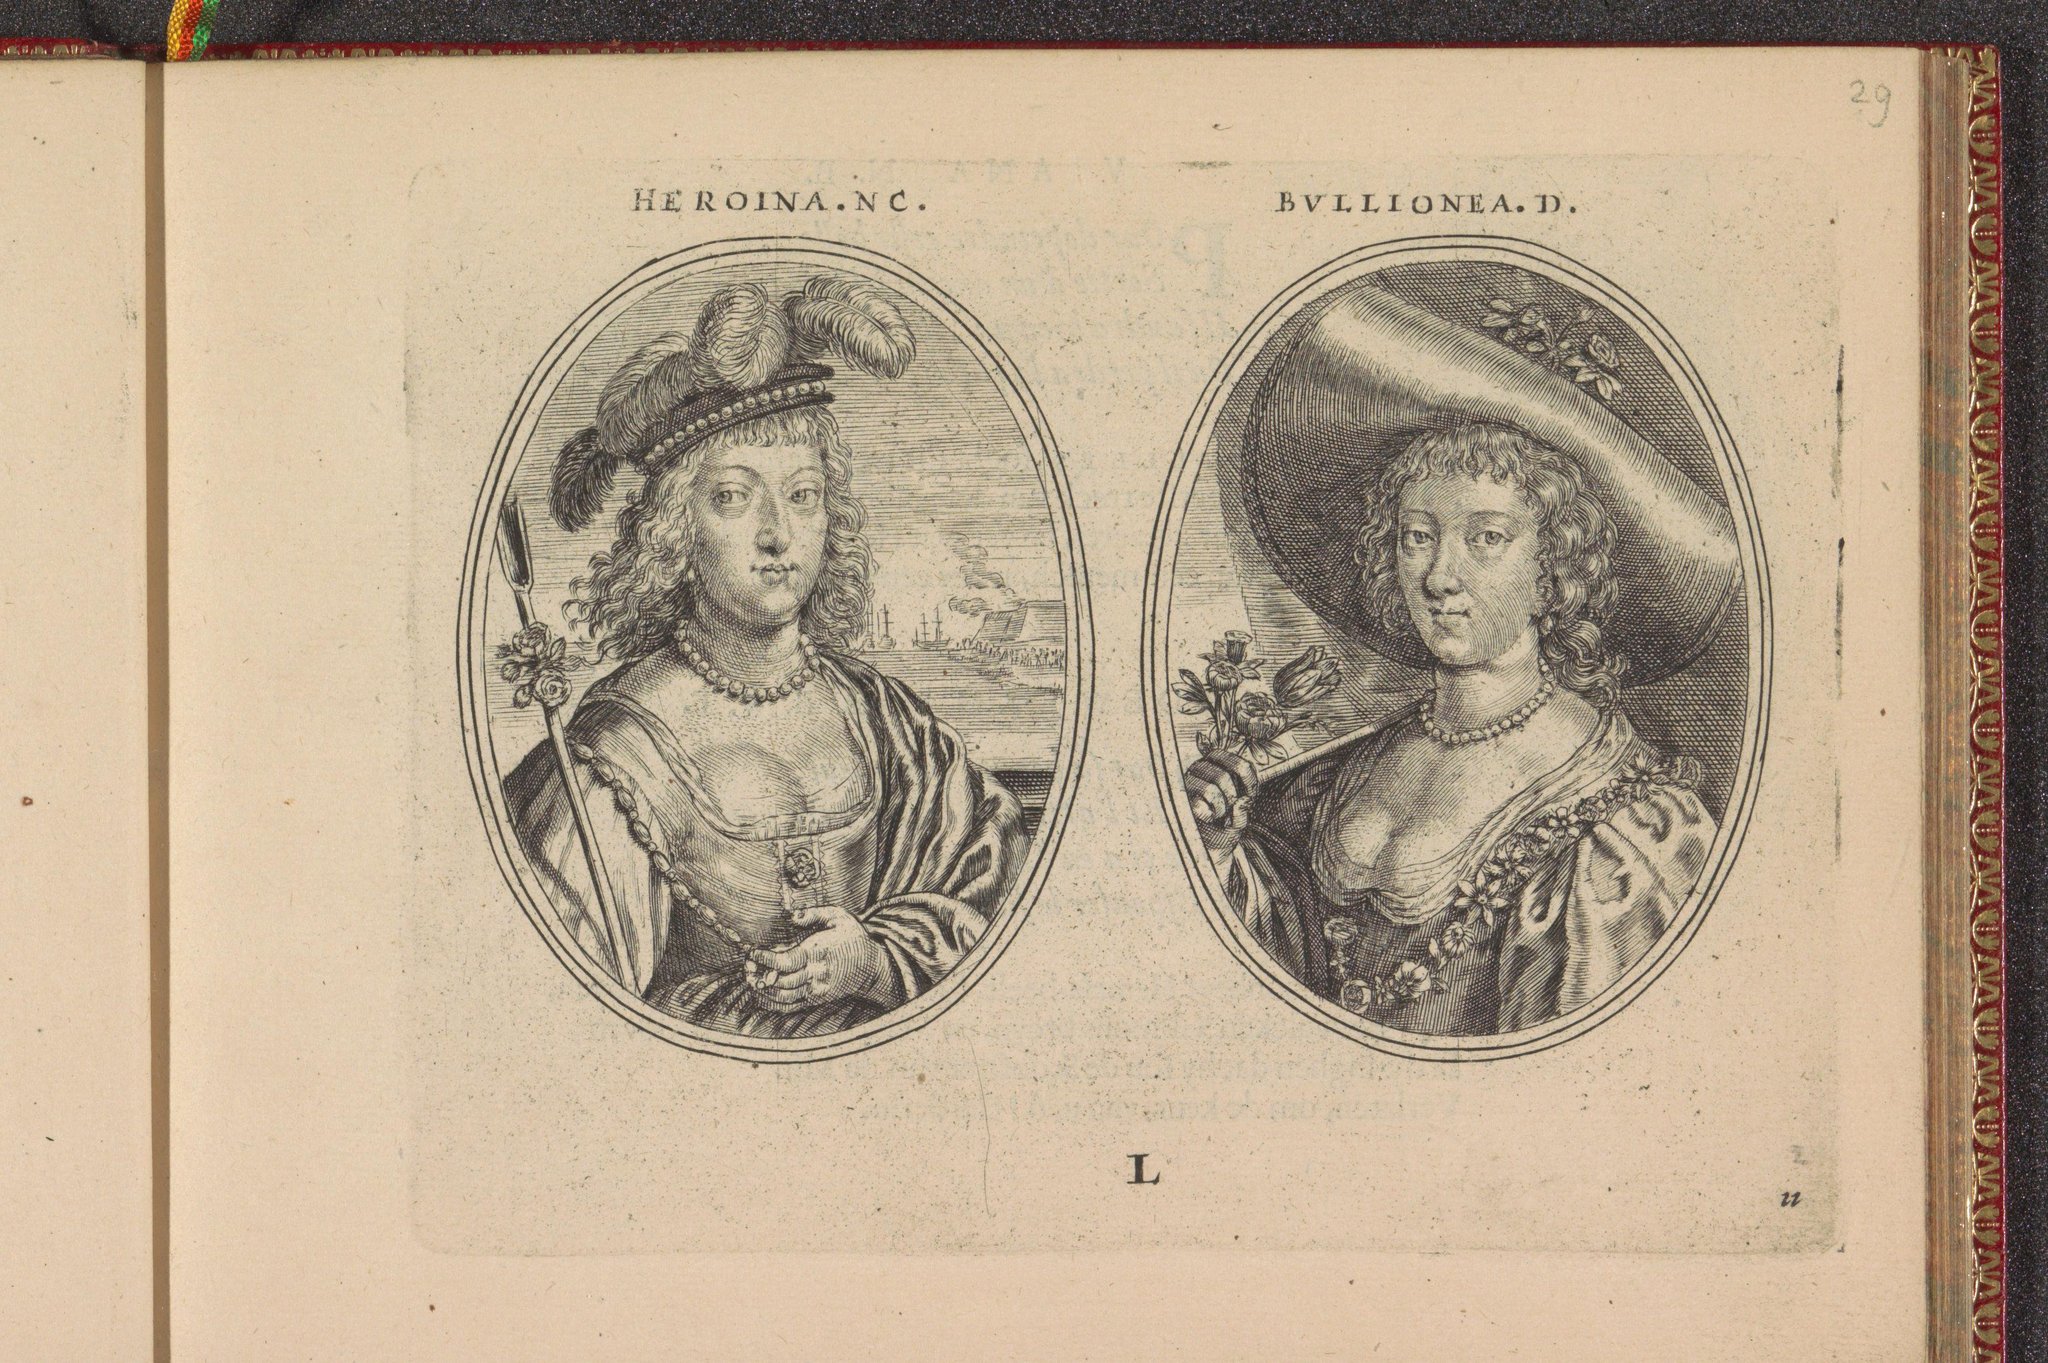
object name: album leaf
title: Portretten van een onbekende hooggeplaatste vrouw en gravin hertogin Elisabeth van Bouillon, beiden als herderin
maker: crispijn van de passe (ii)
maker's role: draughtsman, print maker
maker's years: 1594-1670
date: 1640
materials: paper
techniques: engraving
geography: amsterdam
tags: female sex; woman, shepherd's crook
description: Twee voorstellingen op een albumblad. Links het portret van een onbekende hooggeplaatste vrouw als Heroina N.C. Op de achtergrond een fort en schepen. Rechts mogelijk het portret van Elisabeth, hertogin van Bouillon. Beide vrouwen hebben een herdersstaf in de hand. Onderaan genummerd: L en 11. Het blad maakt deel uit van een album.